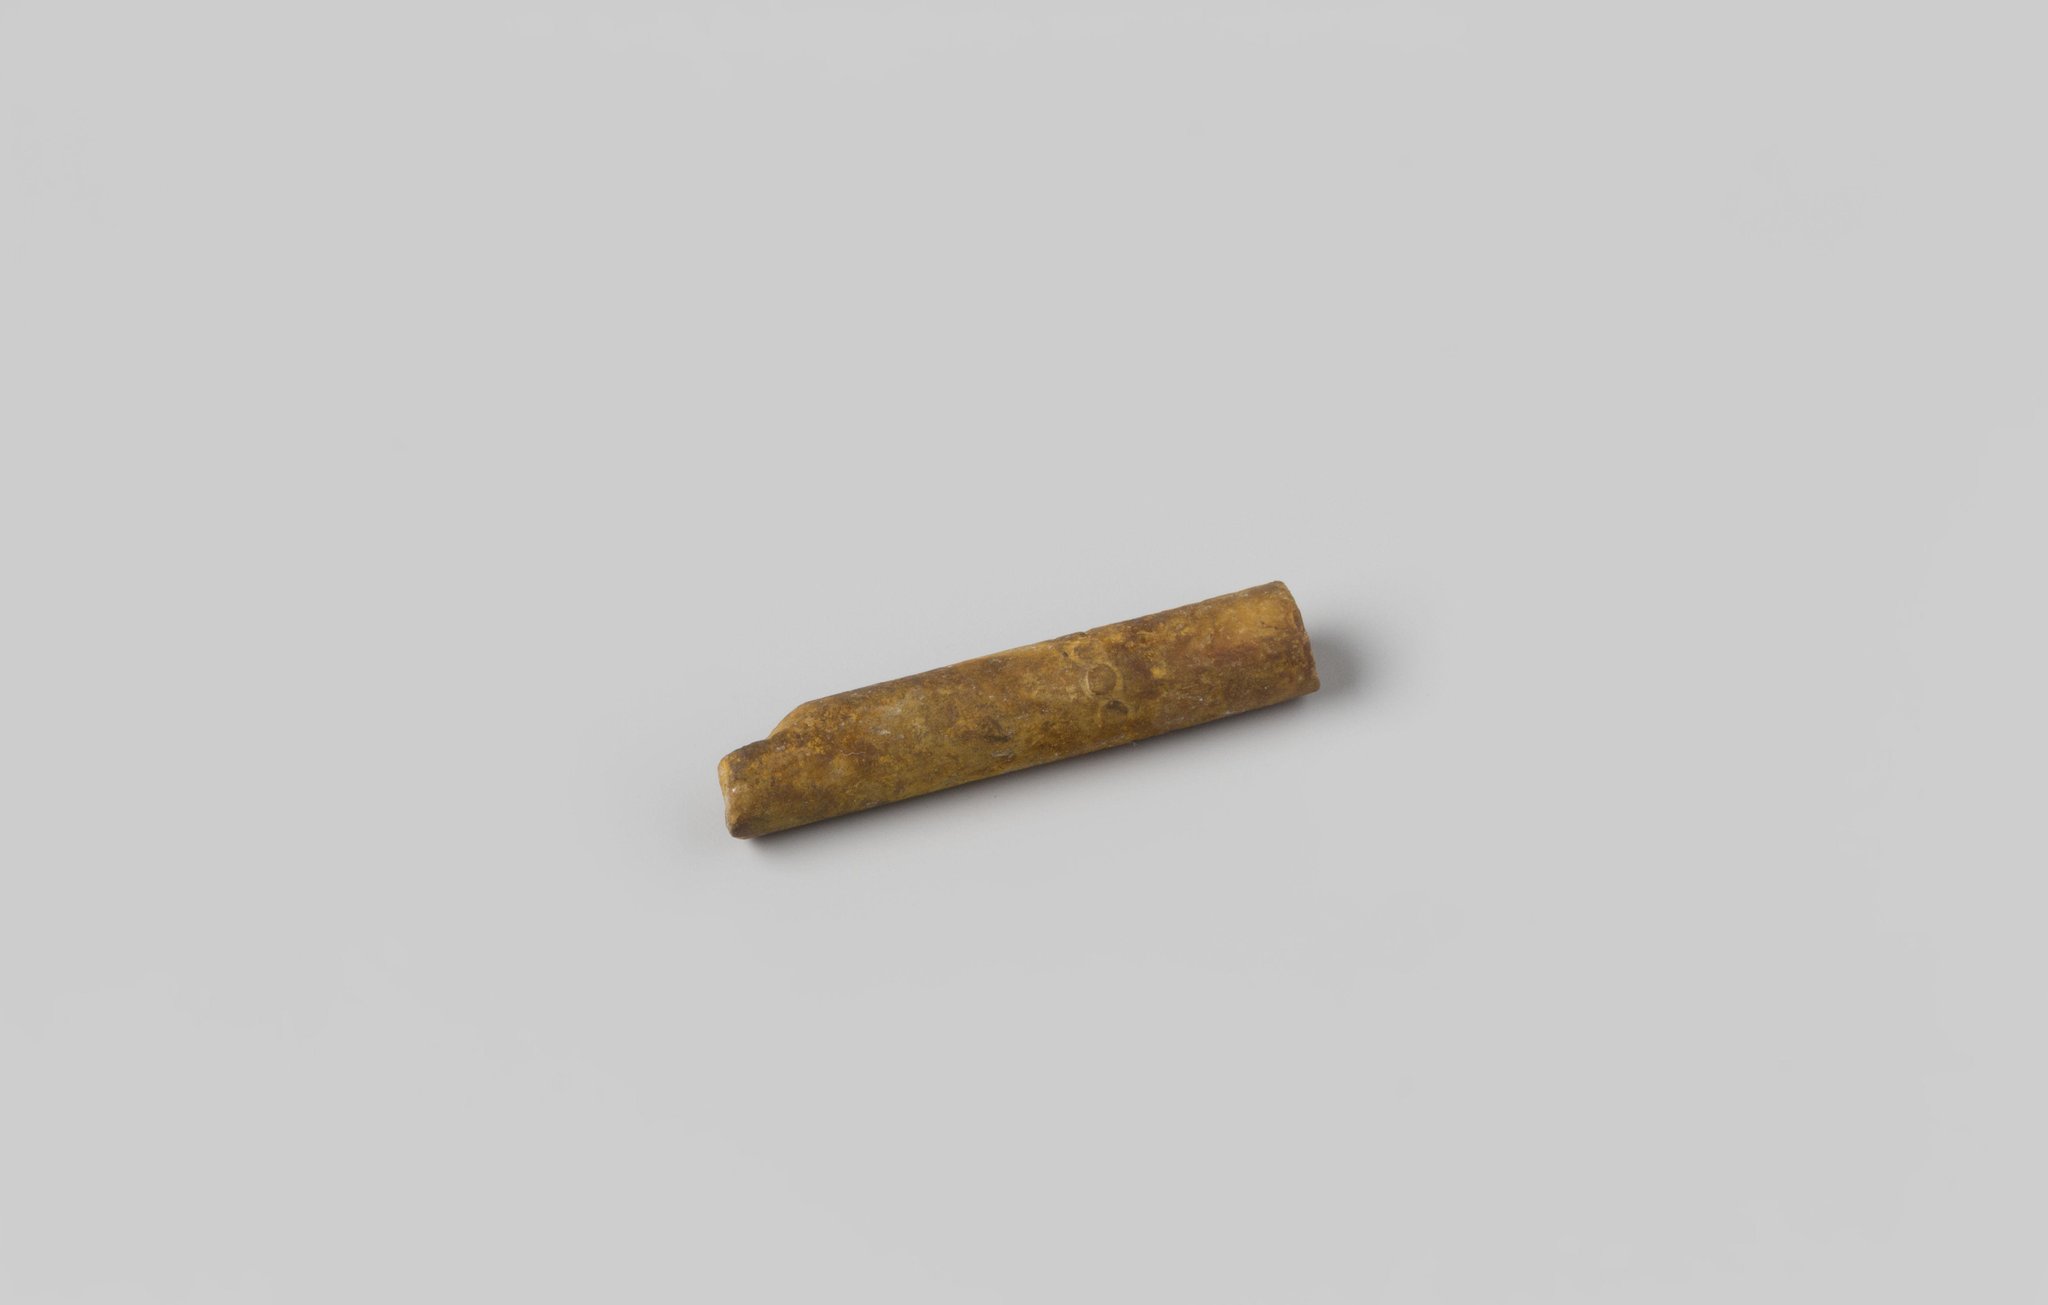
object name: pipe stem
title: Fragmenten pijpensteel uit het wrak van de Oost-Indiëvaarder Hollandia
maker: Anonymous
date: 1700-1743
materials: clay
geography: netherlands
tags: verenigde oostindische compagnie, hollandia (schip), annet